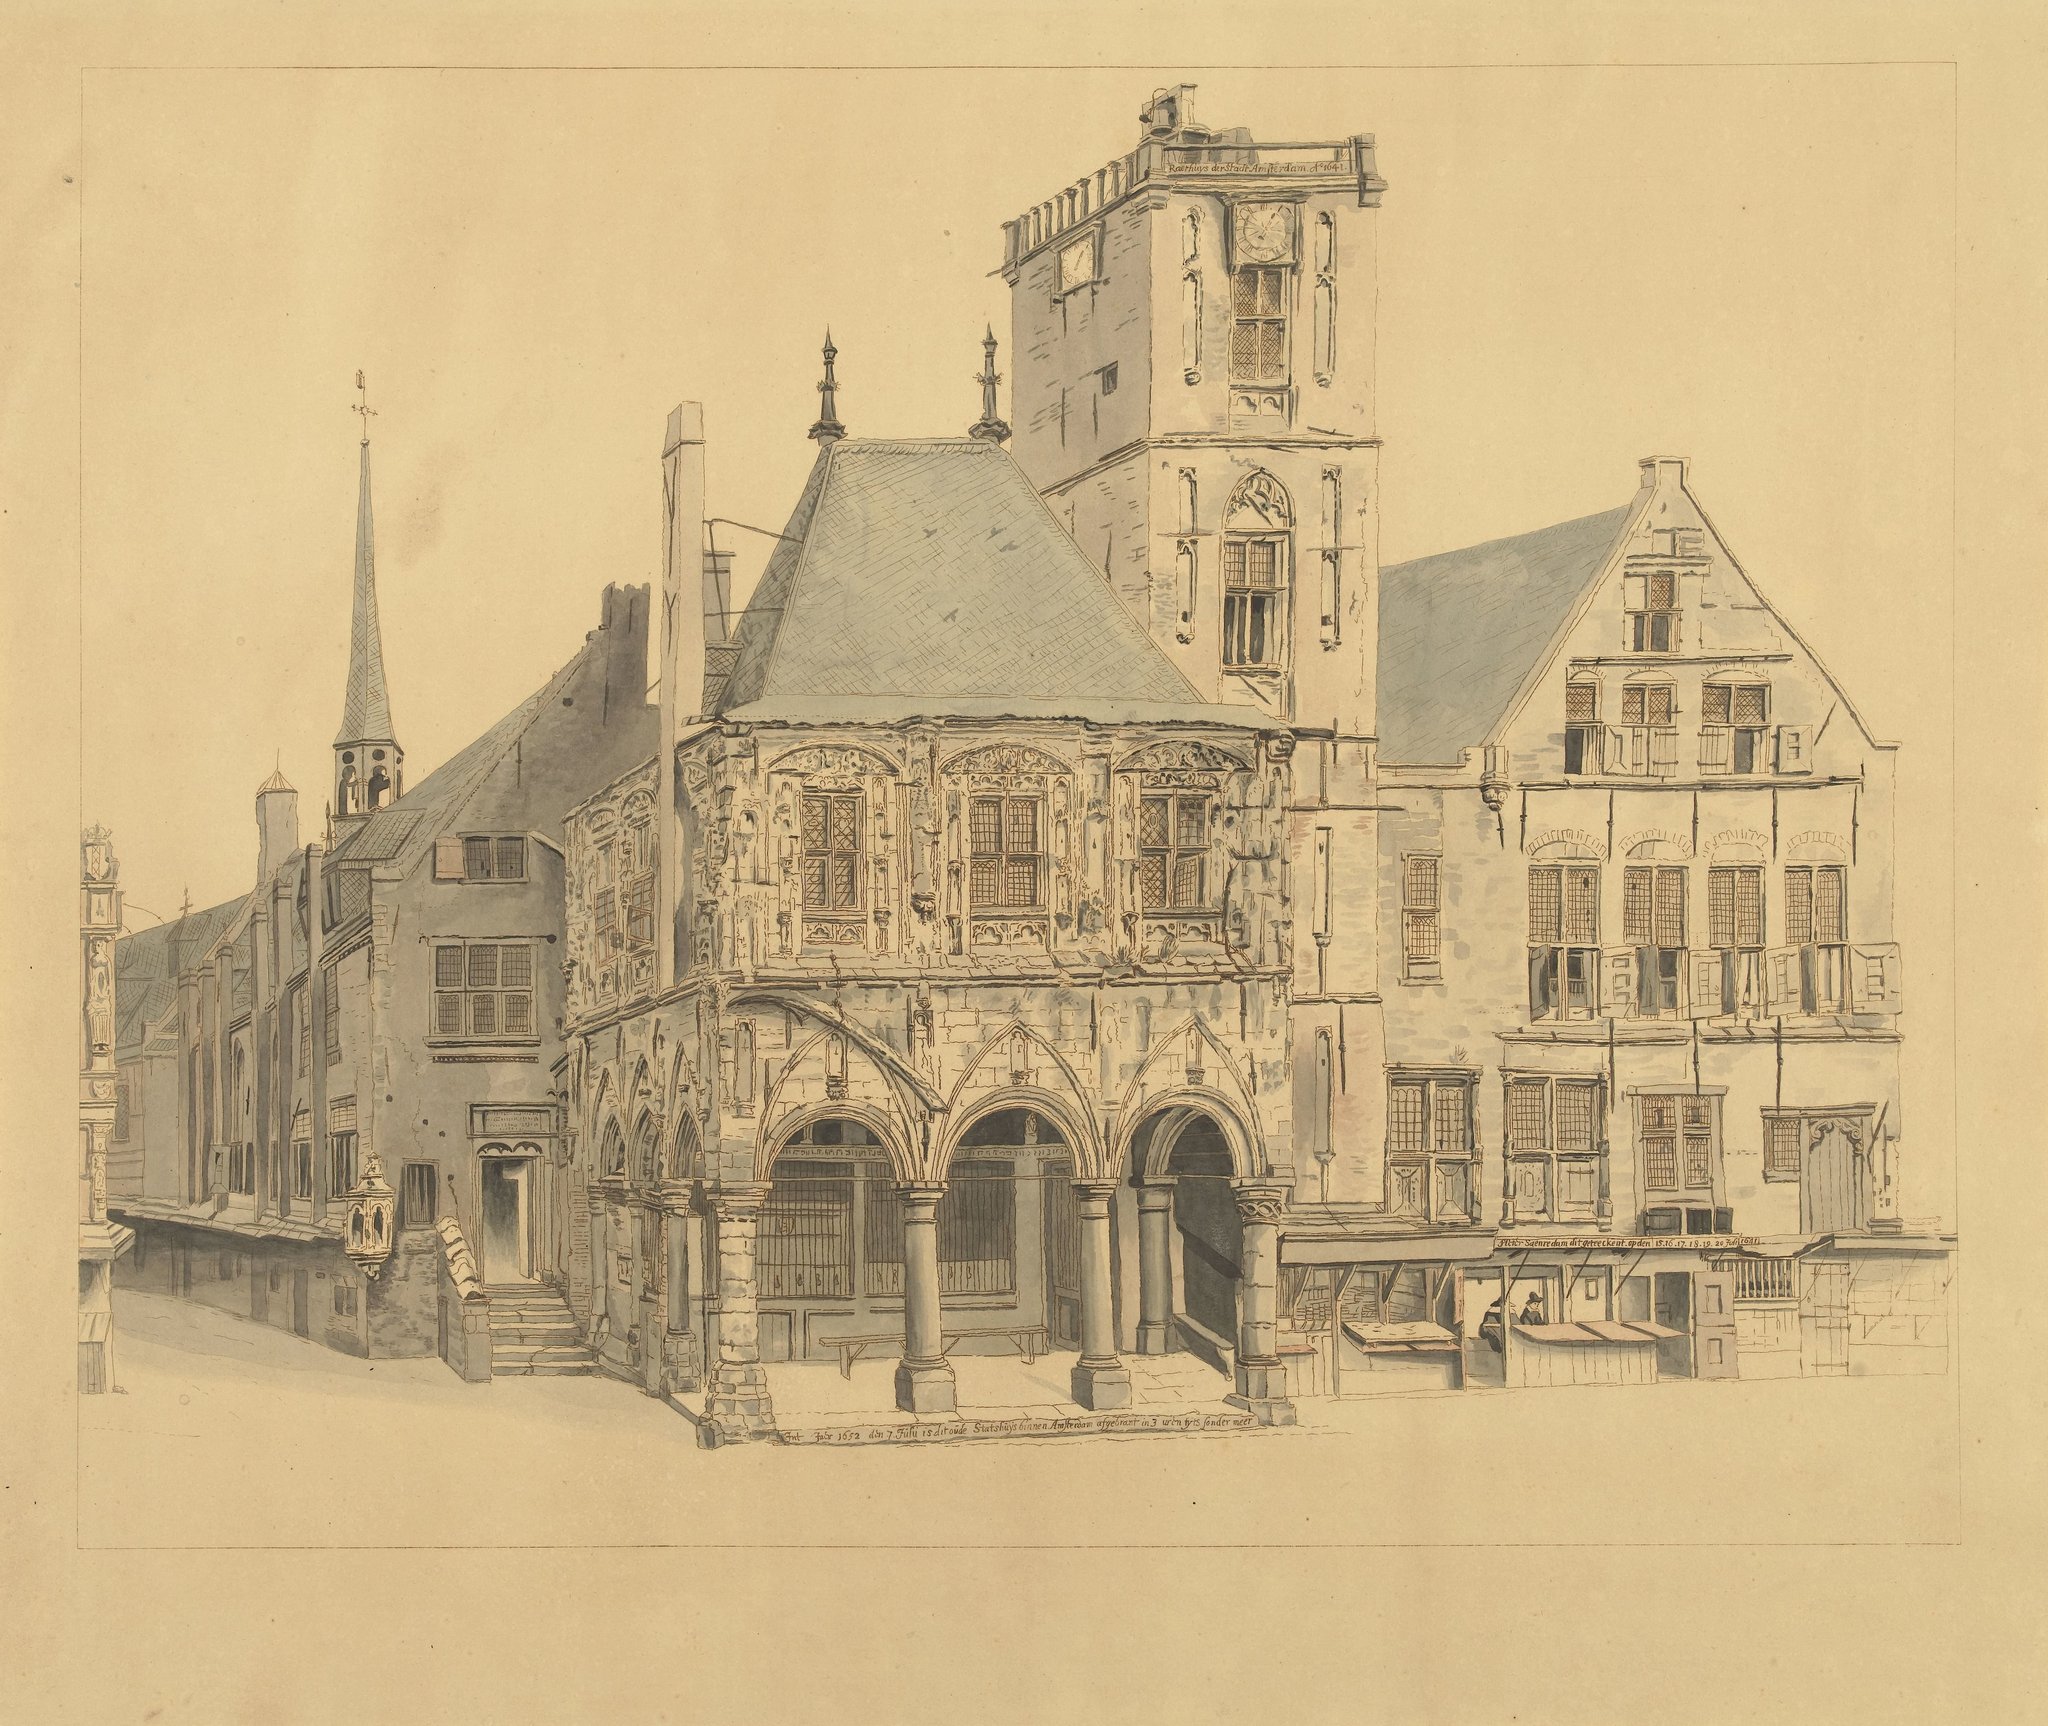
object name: history print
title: Het Oude Stadhuis van Amsterdam, 1641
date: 1778-1838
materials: paper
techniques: brush, etching, hand coloring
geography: netherlands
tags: stadhuis van amsterdam (14e eeuw-1652)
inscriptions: inscription: ‘Anth. van den Bos sculp. No. 9’, collector's mark: Lugt 2228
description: Het Oude Stadhuis van Amsterdam, naar de tekening van 20 juni 1641. Op de stenen van de drempel een inscriptie over het afbranden van het stadhuis op 7 juli 1652.